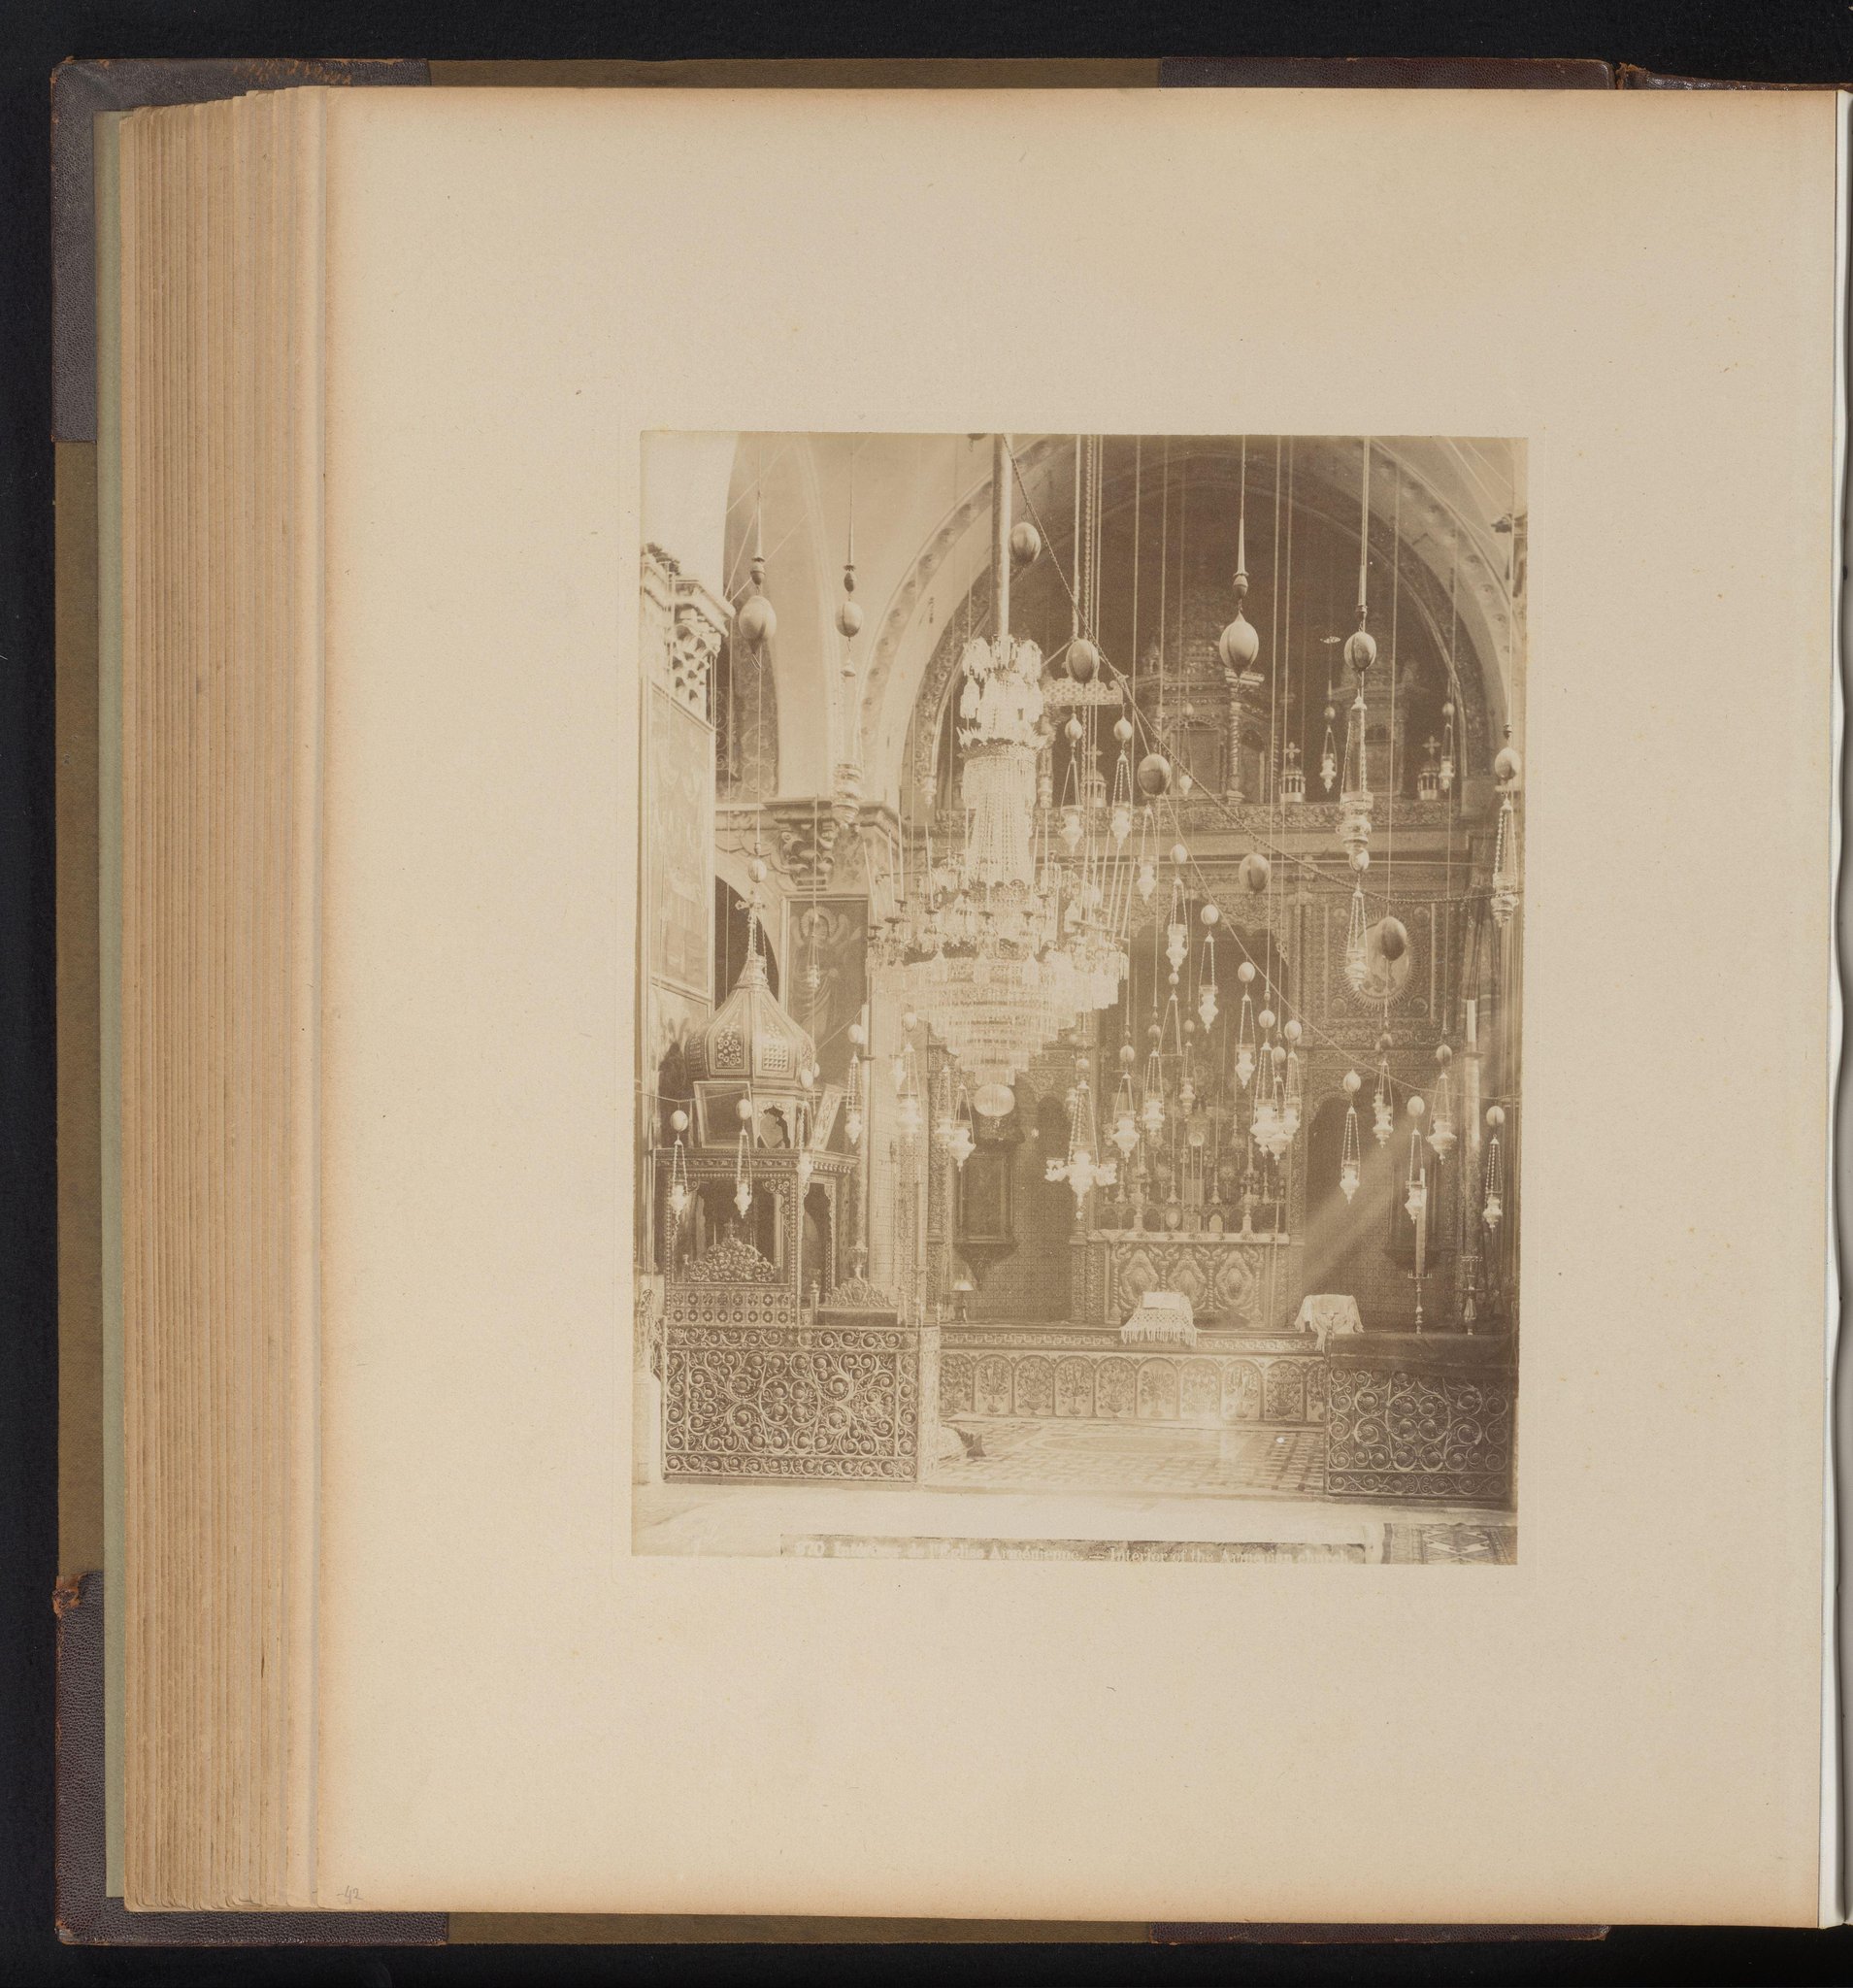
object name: photograph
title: Kapel van Sint-Helena in de Heilig Grafkerk in Jeruzalem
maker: félix bonfils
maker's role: fotograaf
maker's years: 1831-1885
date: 1867-1885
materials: paper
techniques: albumen print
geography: jerusalem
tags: interior of church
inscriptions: number: ‘870’